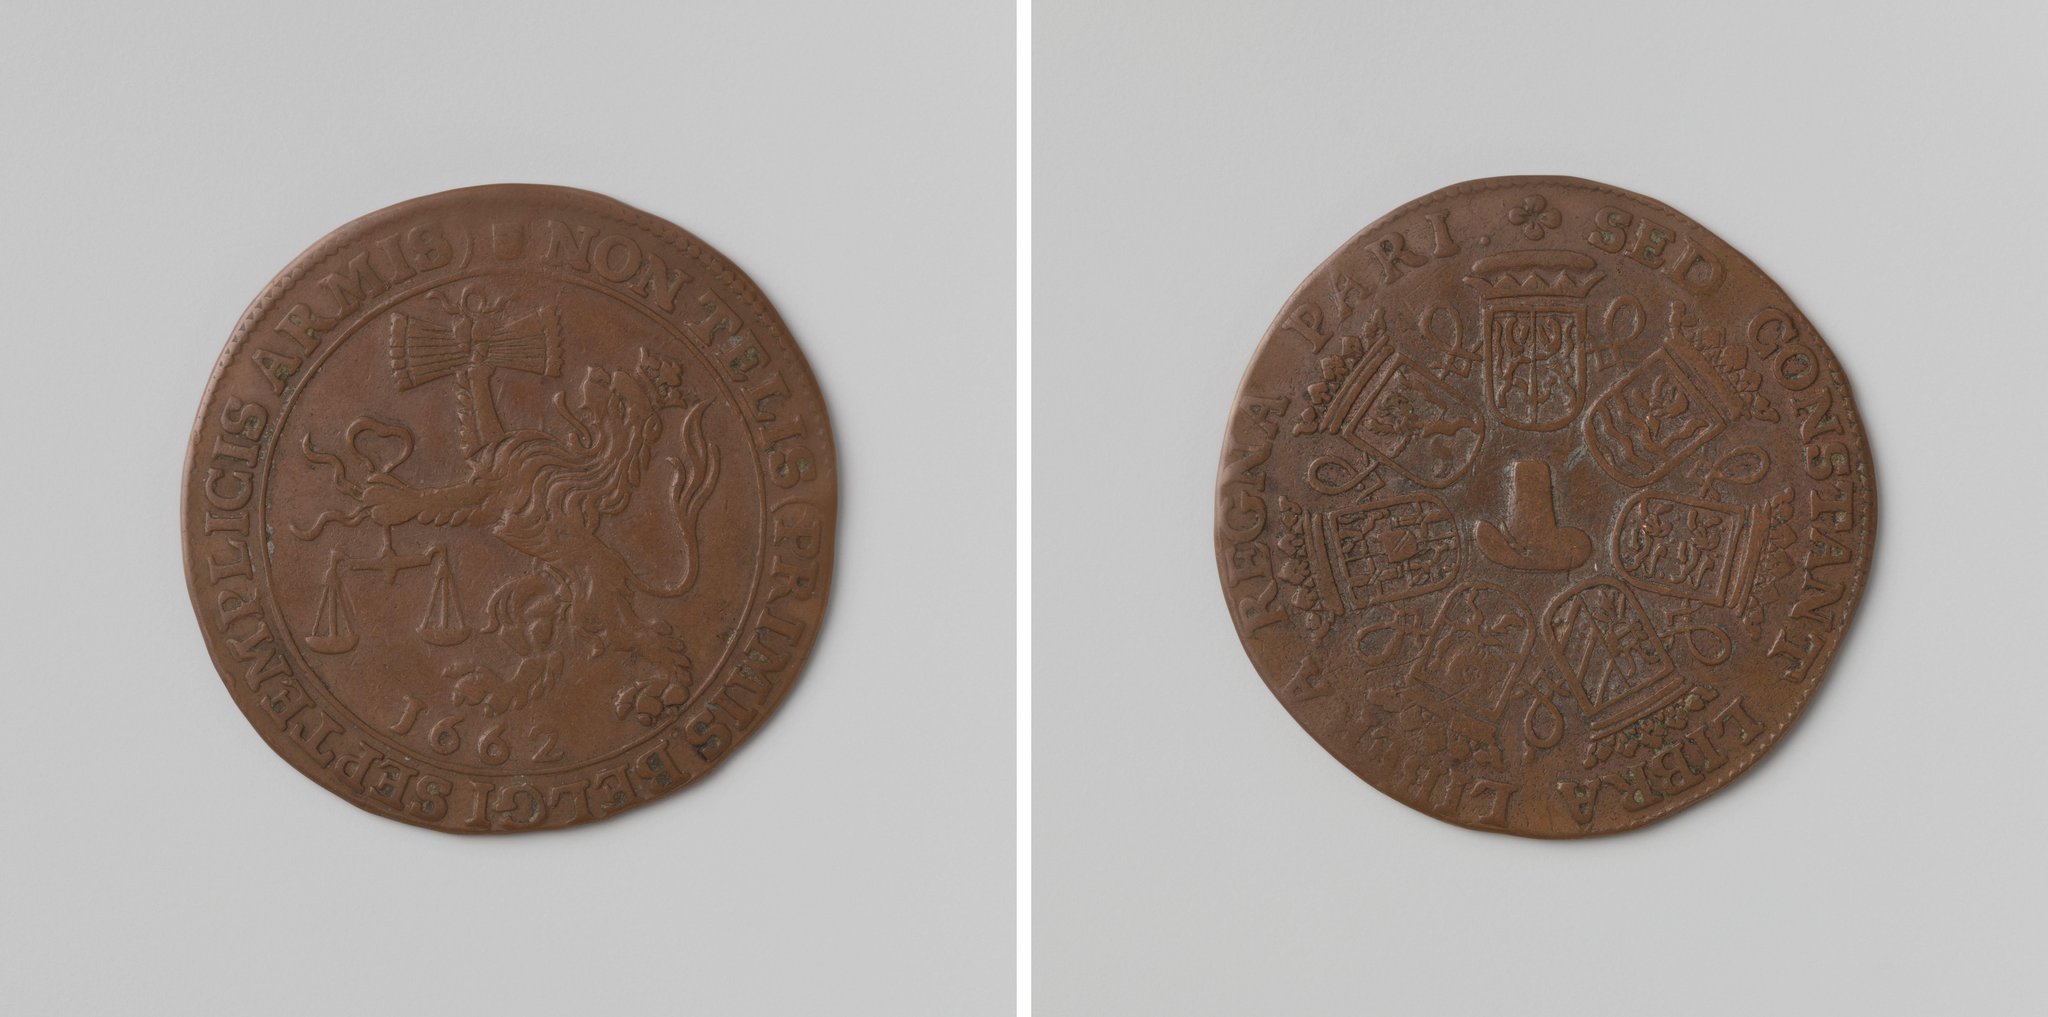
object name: jeton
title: Sluiting van een handelsverbond tussen de Republiek, Engeland en Frankrijk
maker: Anonymous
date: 1662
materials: copper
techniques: striking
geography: utrecht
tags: france, england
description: Koperen penning. Voorzijde: gekroonde leeuw met bundel van zeven pijlen in rechter- en weegschaal in linkerklauw boven jaartal binnen omschrift. Keerzijde: vrijheidshoed, omgeven door rand van zeven met lint samengebonden gekroonde wapenschilden binnen omschrift